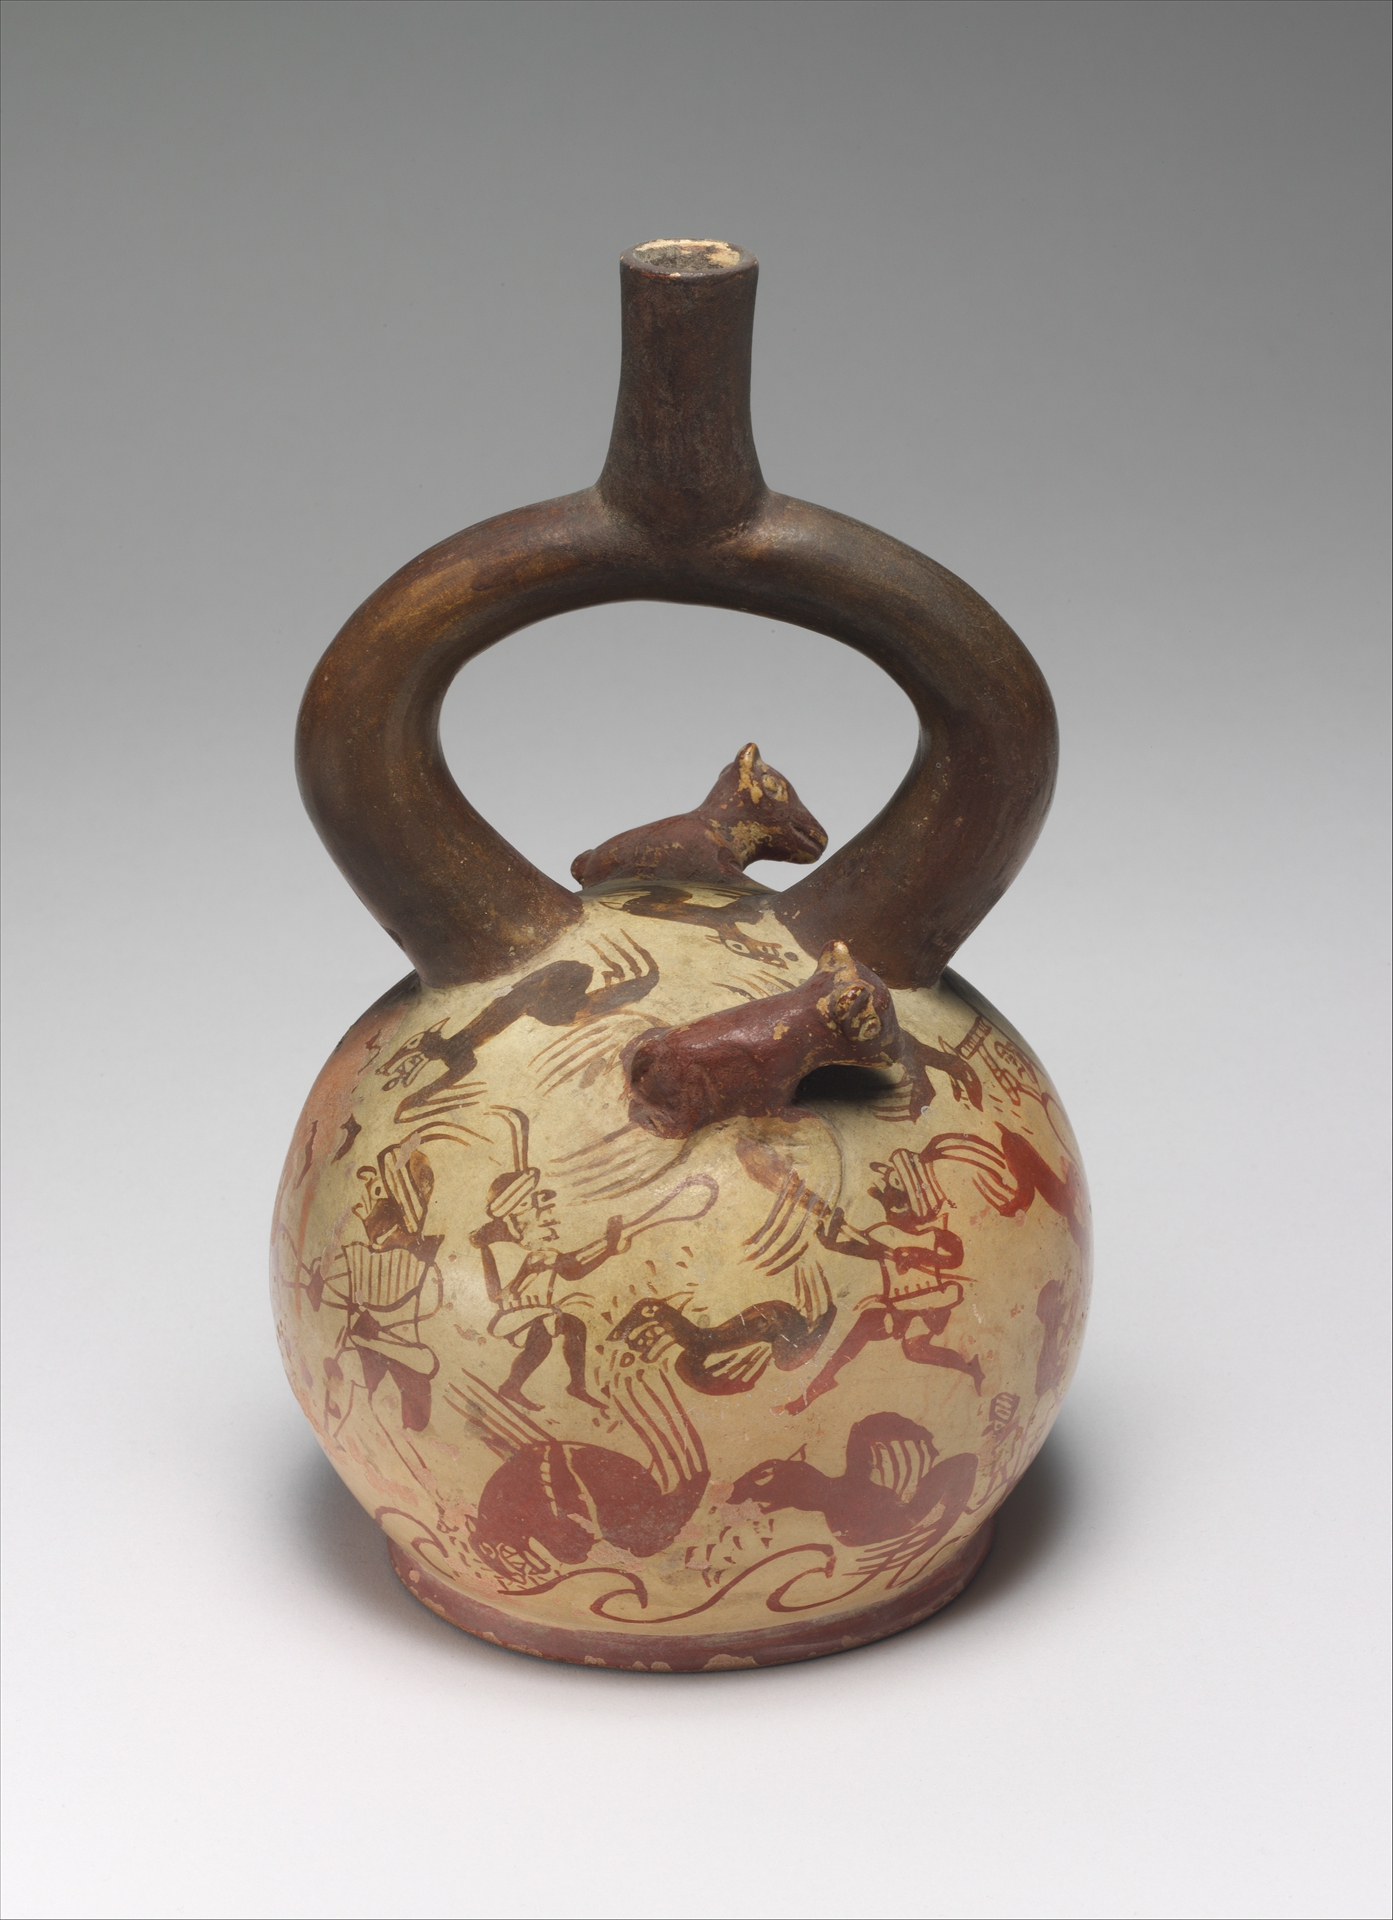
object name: bottle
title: Sea Lion Hunt Bottle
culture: moche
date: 501-700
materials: ceramic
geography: peru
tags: animals,men,hunting